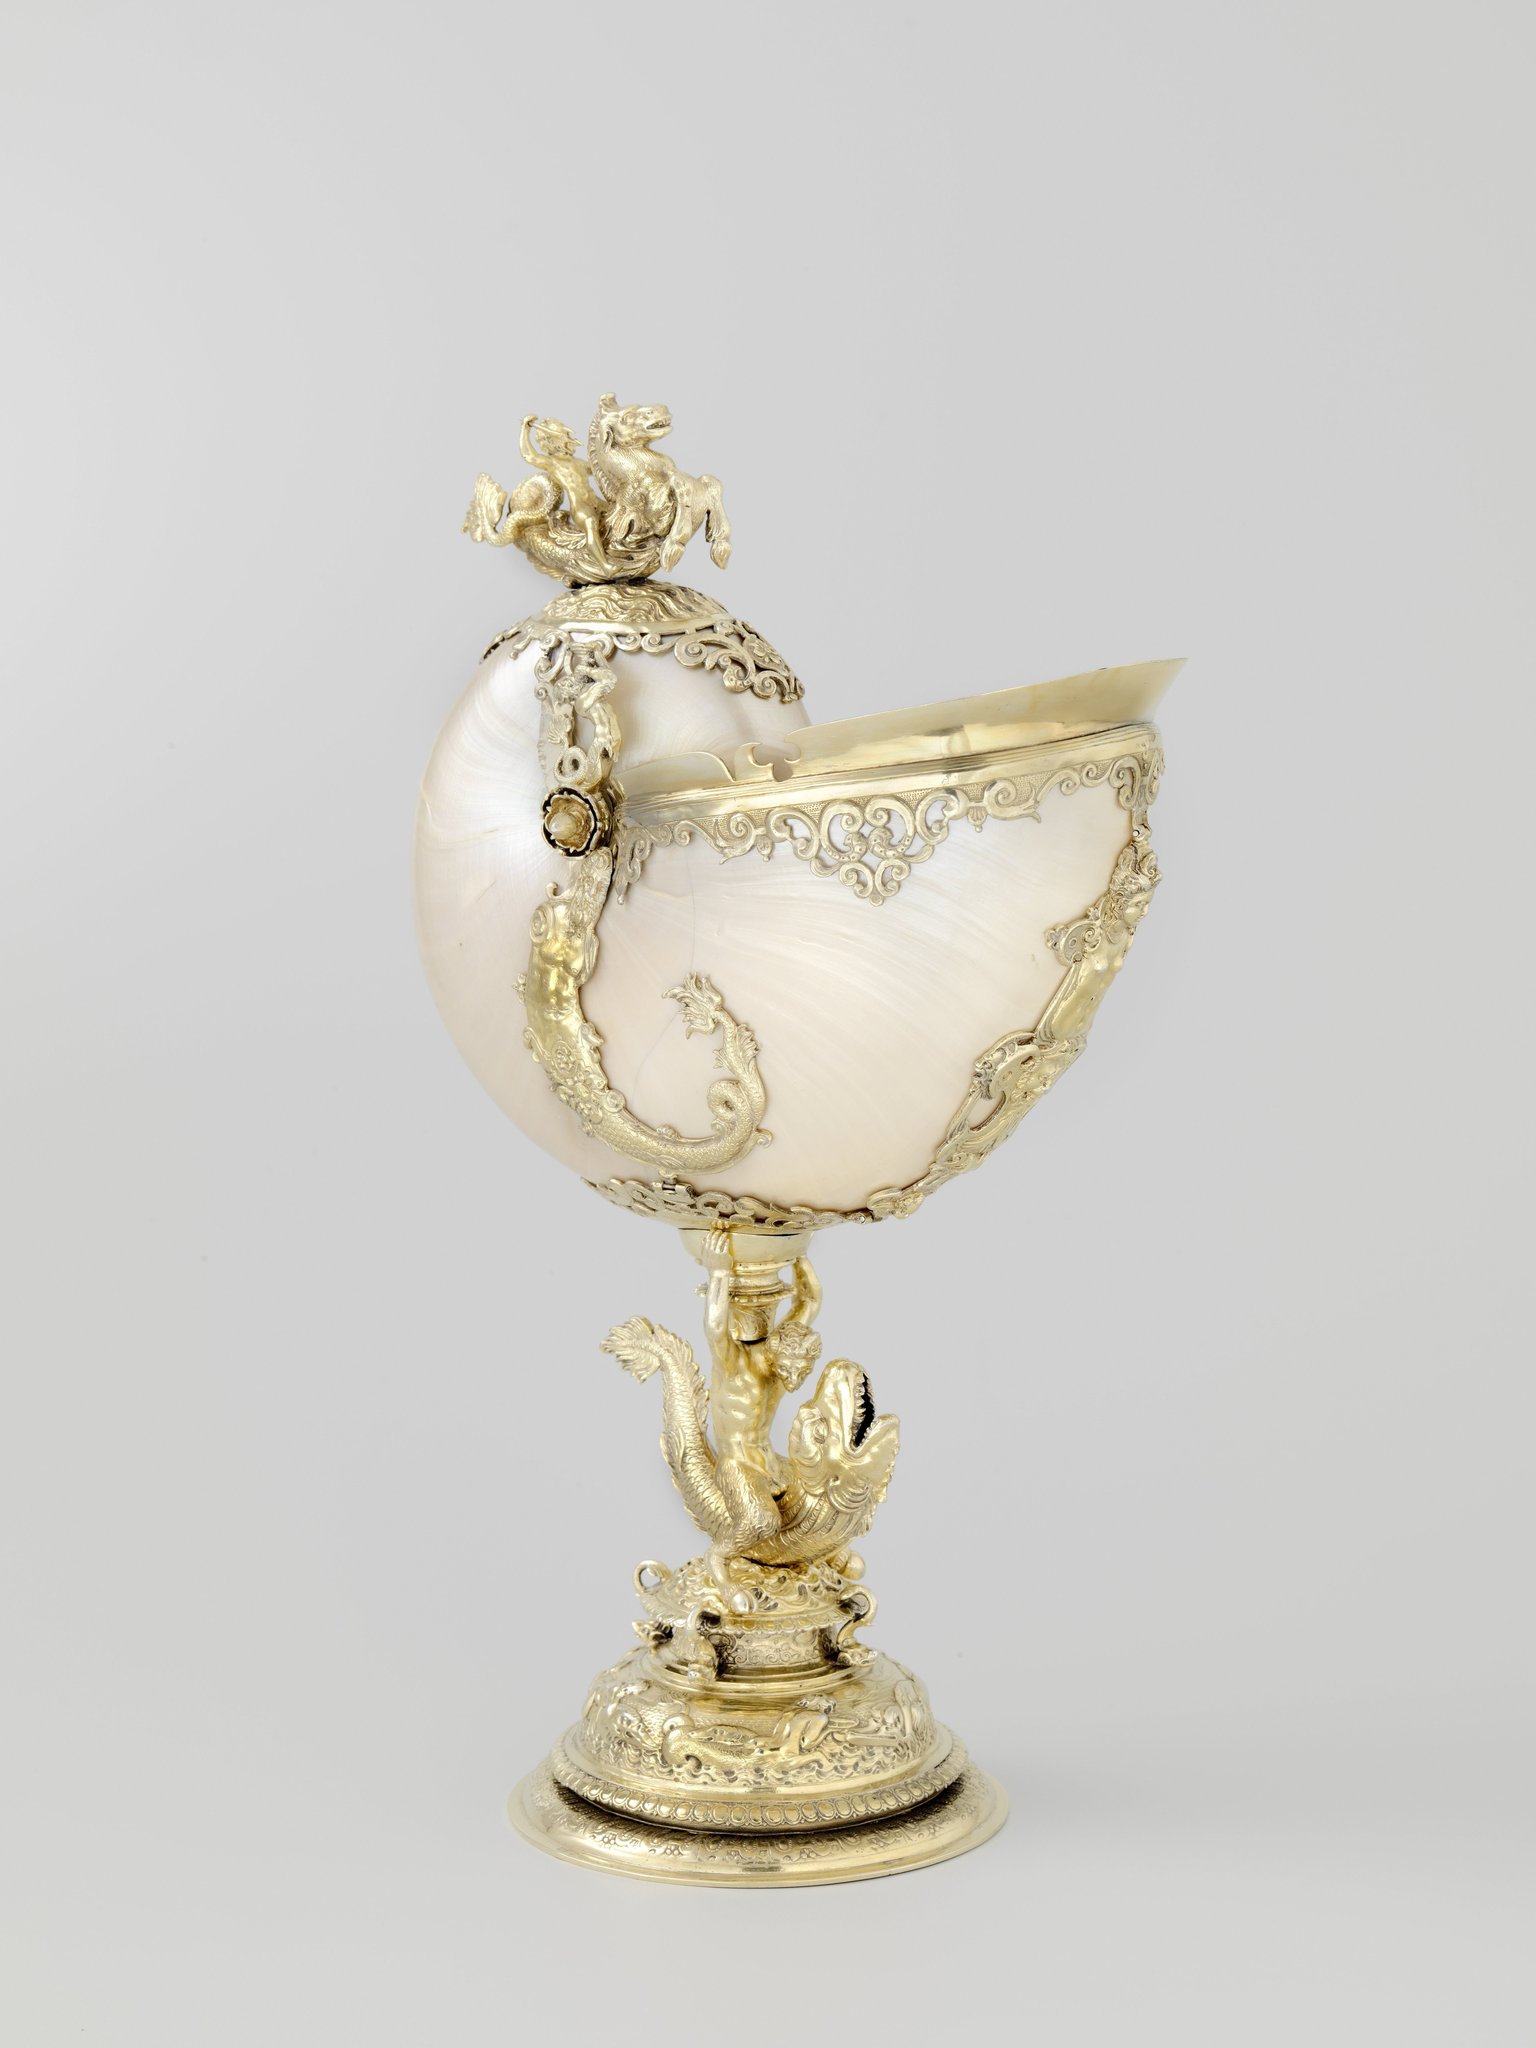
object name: nautilus shell cup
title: Nautilus cup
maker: Anonymous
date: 1590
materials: shell, silver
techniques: gilding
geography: low countries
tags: (story of) neptune (poseidon), dolphin ~ ornament, offspring, companion(s), train etc. of neptune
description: Nautilusbeker met verguld zilveren montuur, staande op een voet met twee godronranden en een stoet tritons op de welving. Daarboven, op een klein, door losse voluten omgeven plateau, een dolfijn met op de rug een satyr, die de schelp ondersteunt. De schelp is gevat in drie klampen; aan de voorzijde een kariatide en aan weerszijden een hermtriton met gezwenkte, kronkelende staart. Bij de rozetvormige moer nabij de mondrand twee kleinere tritons. Langs de mondrand in punten afhangend, opengewerkt bandwerk. Op de bovenzijde van de schelp een omrande, ovale kap met overeenkomstig afhangend bandwerk. Als bekroning een steigerende hippocamp, waarop Neptunus is gezeten.